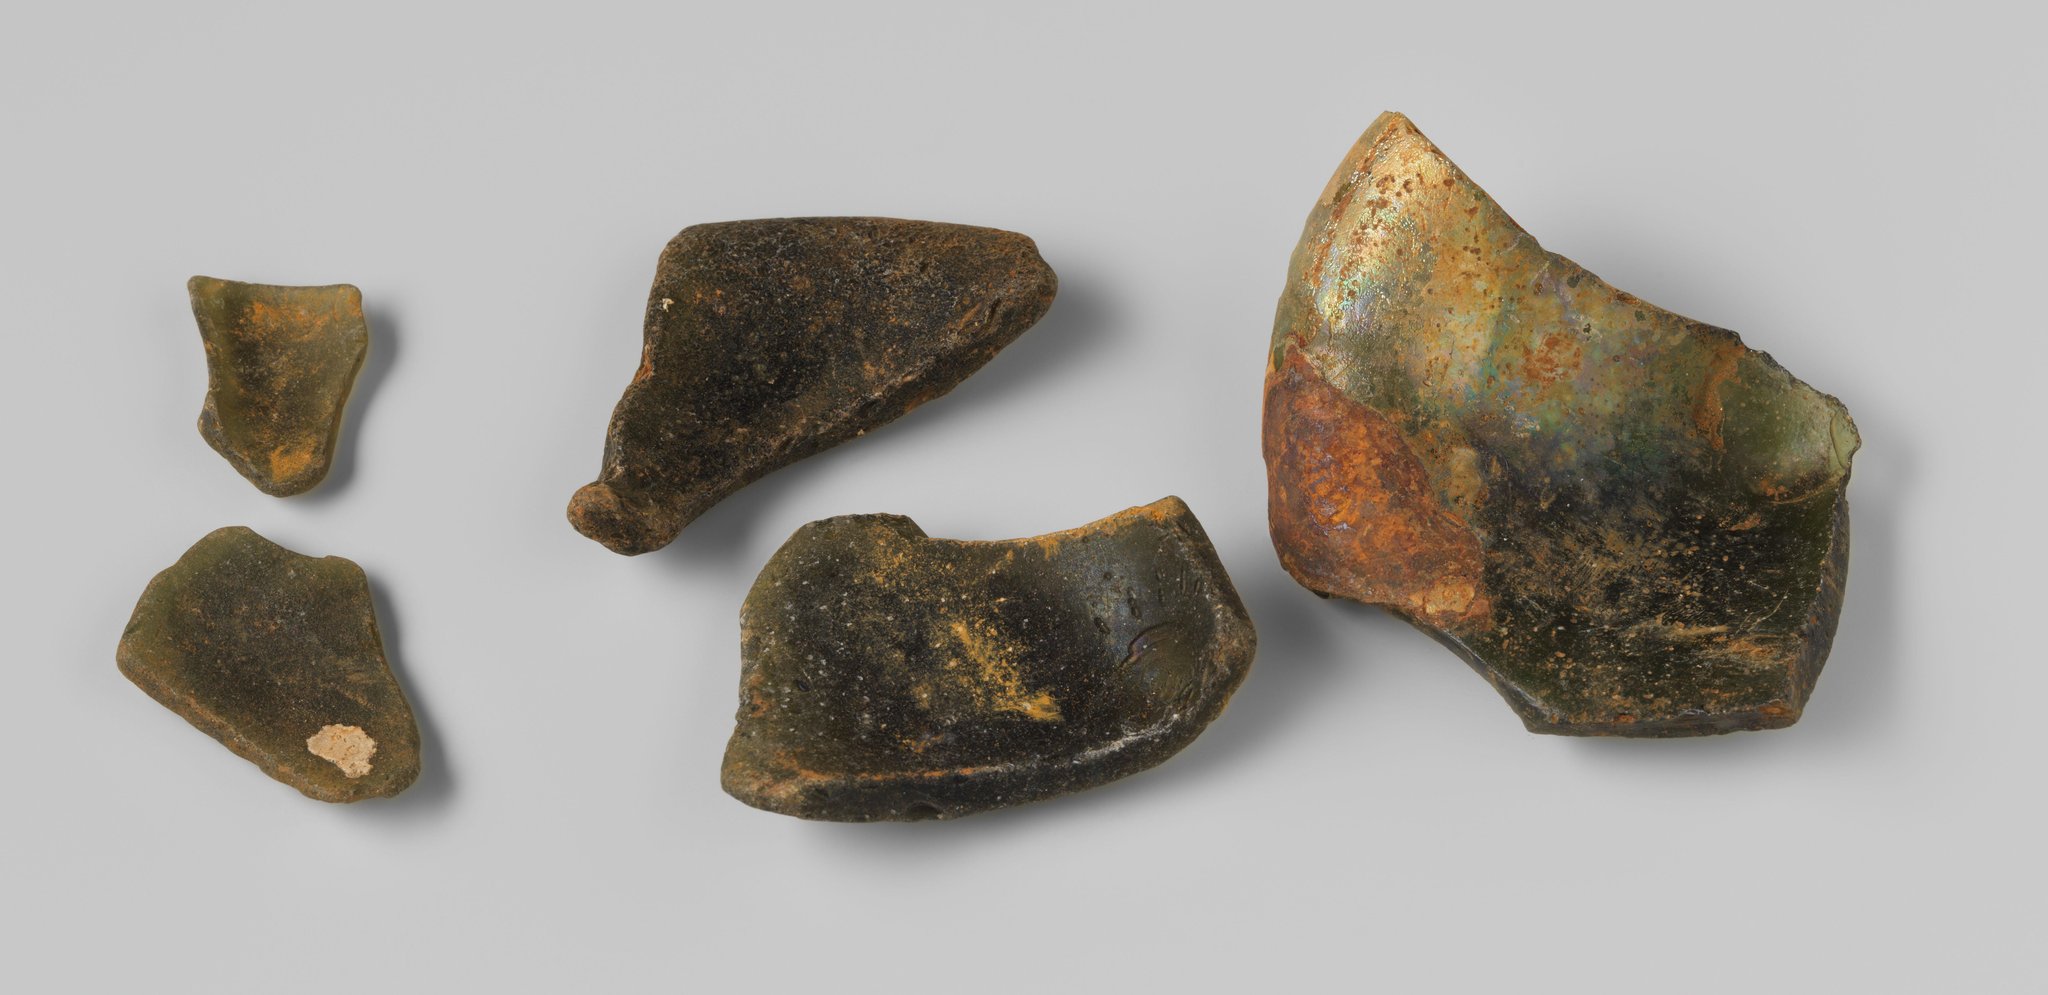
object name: wine bottle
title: Scherven van wijnflessen uit het wrak van de Oostindiëvaarder Hollandia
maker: Anonymous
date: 1700-1743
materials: glass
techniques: green glass